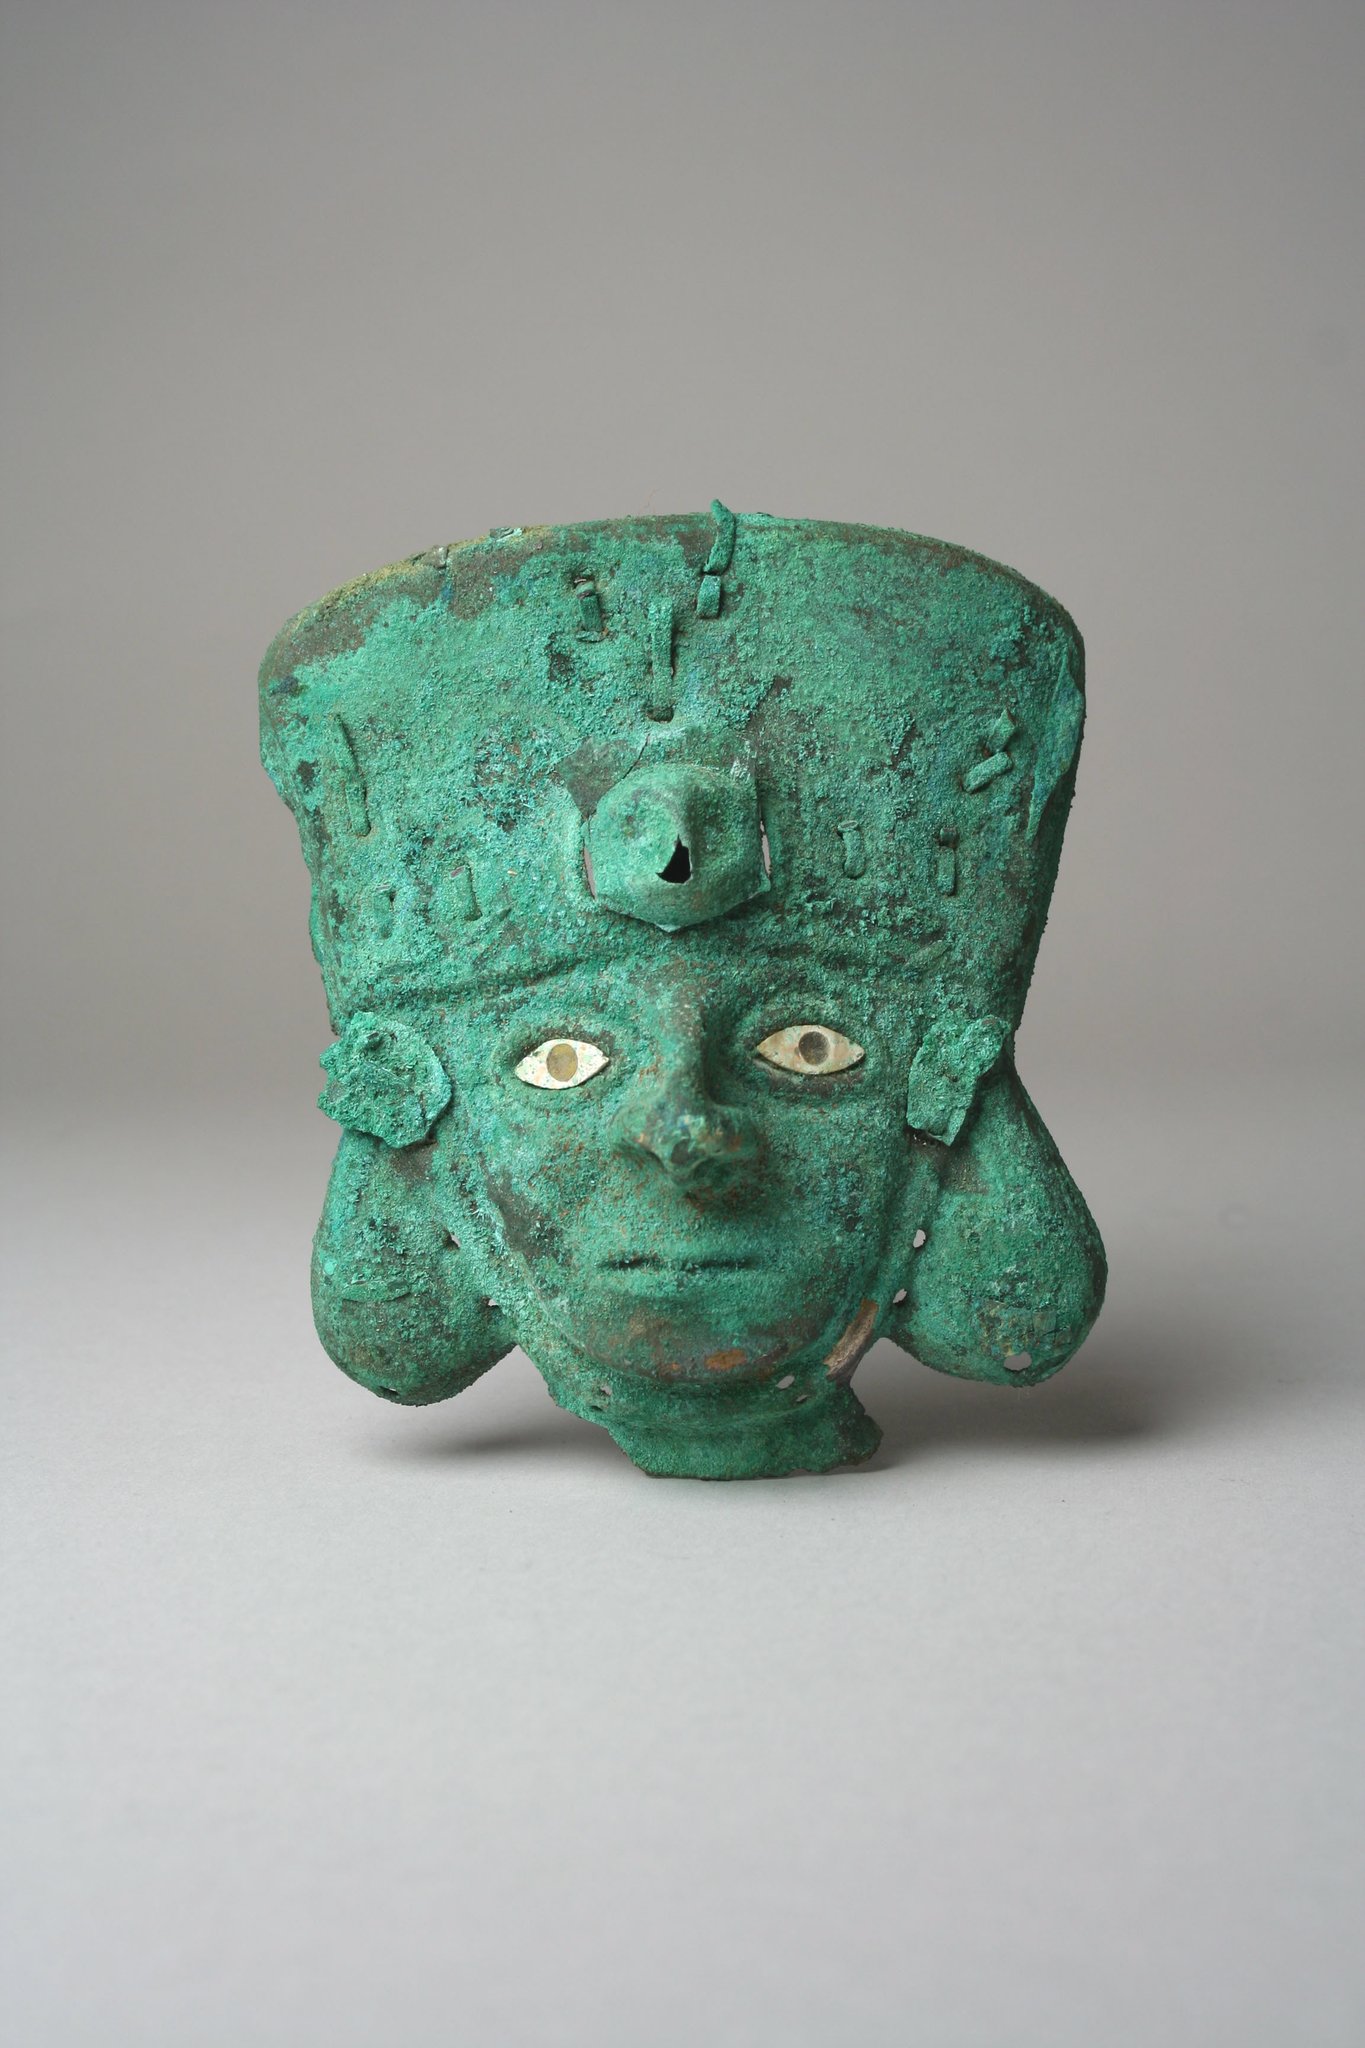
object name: ornament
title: Face Mask Ornament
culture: moche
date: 501-700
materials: copper, shell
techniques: gilding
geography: peru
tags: faces